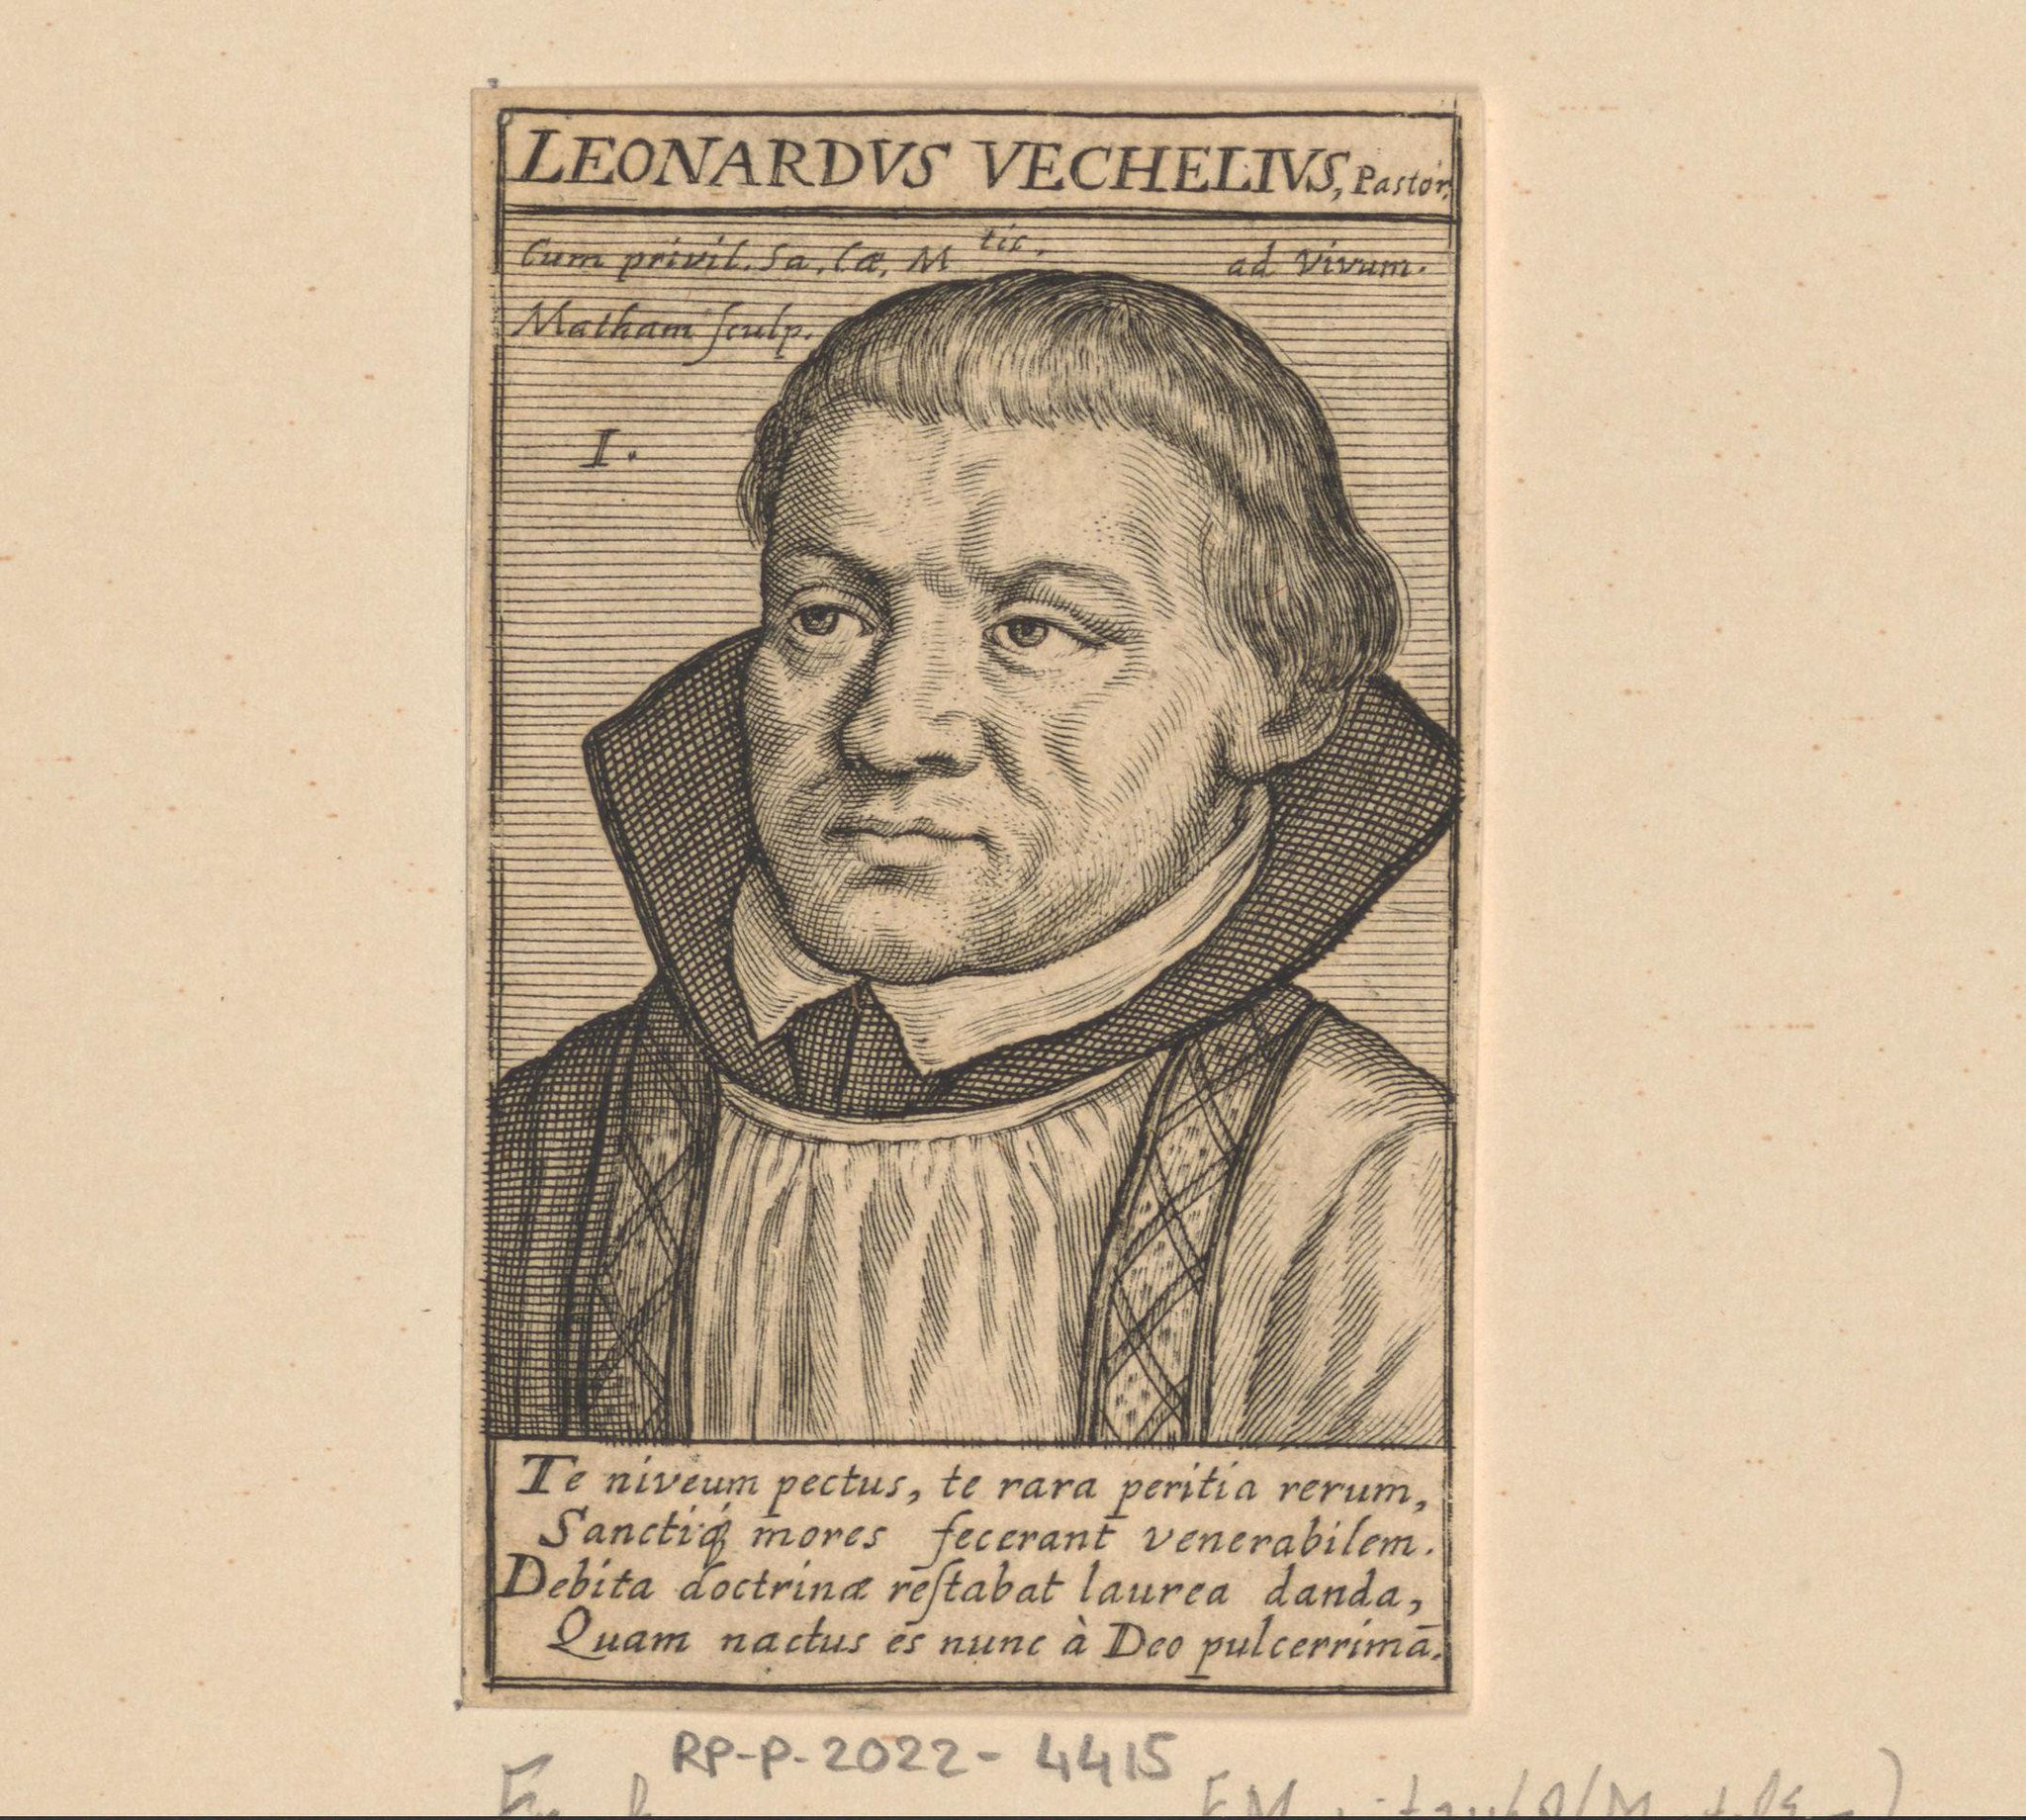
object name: print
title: Martelaren van Gorcum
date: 1617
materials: paper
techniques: engraving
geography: haarlem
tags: den bosch, brielle, martyrs of gorkum, theologian, historical persons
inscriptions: collector's mark: Lugt 964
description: Met een vierregelig onderschrift in het Latijn.